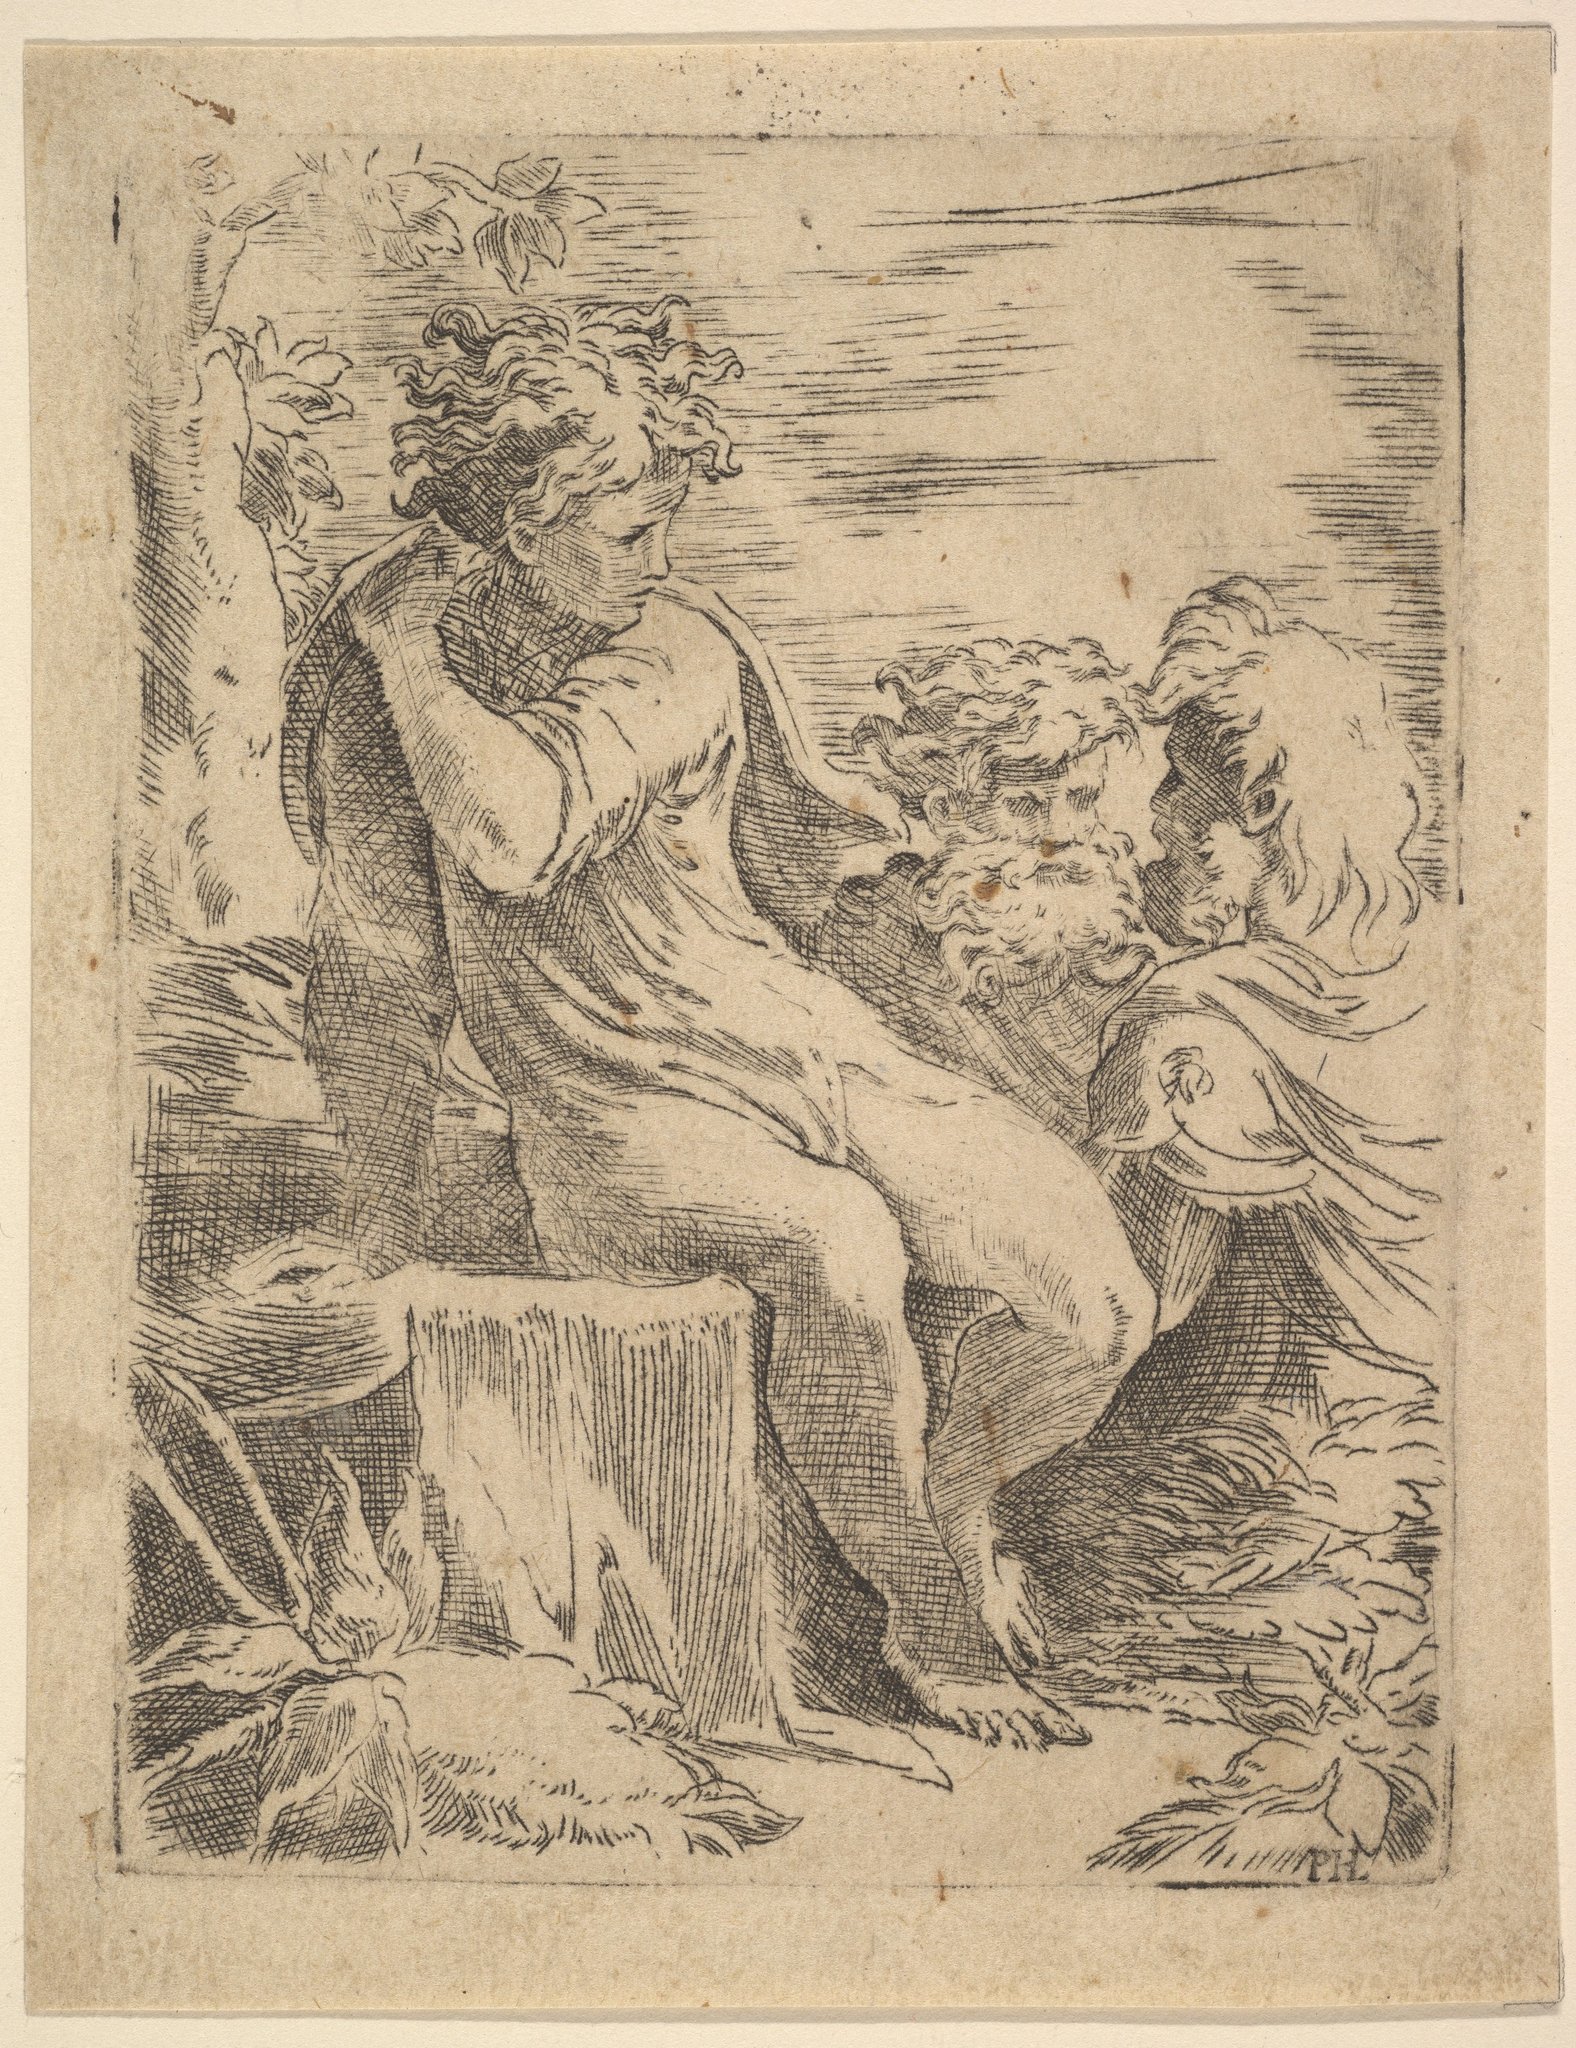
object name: print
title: Youth with two old Men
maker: anonymous, italian, 16th century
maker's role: artist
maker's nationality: italian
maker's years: 1500-1600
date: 1501-1600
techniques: etching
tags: men